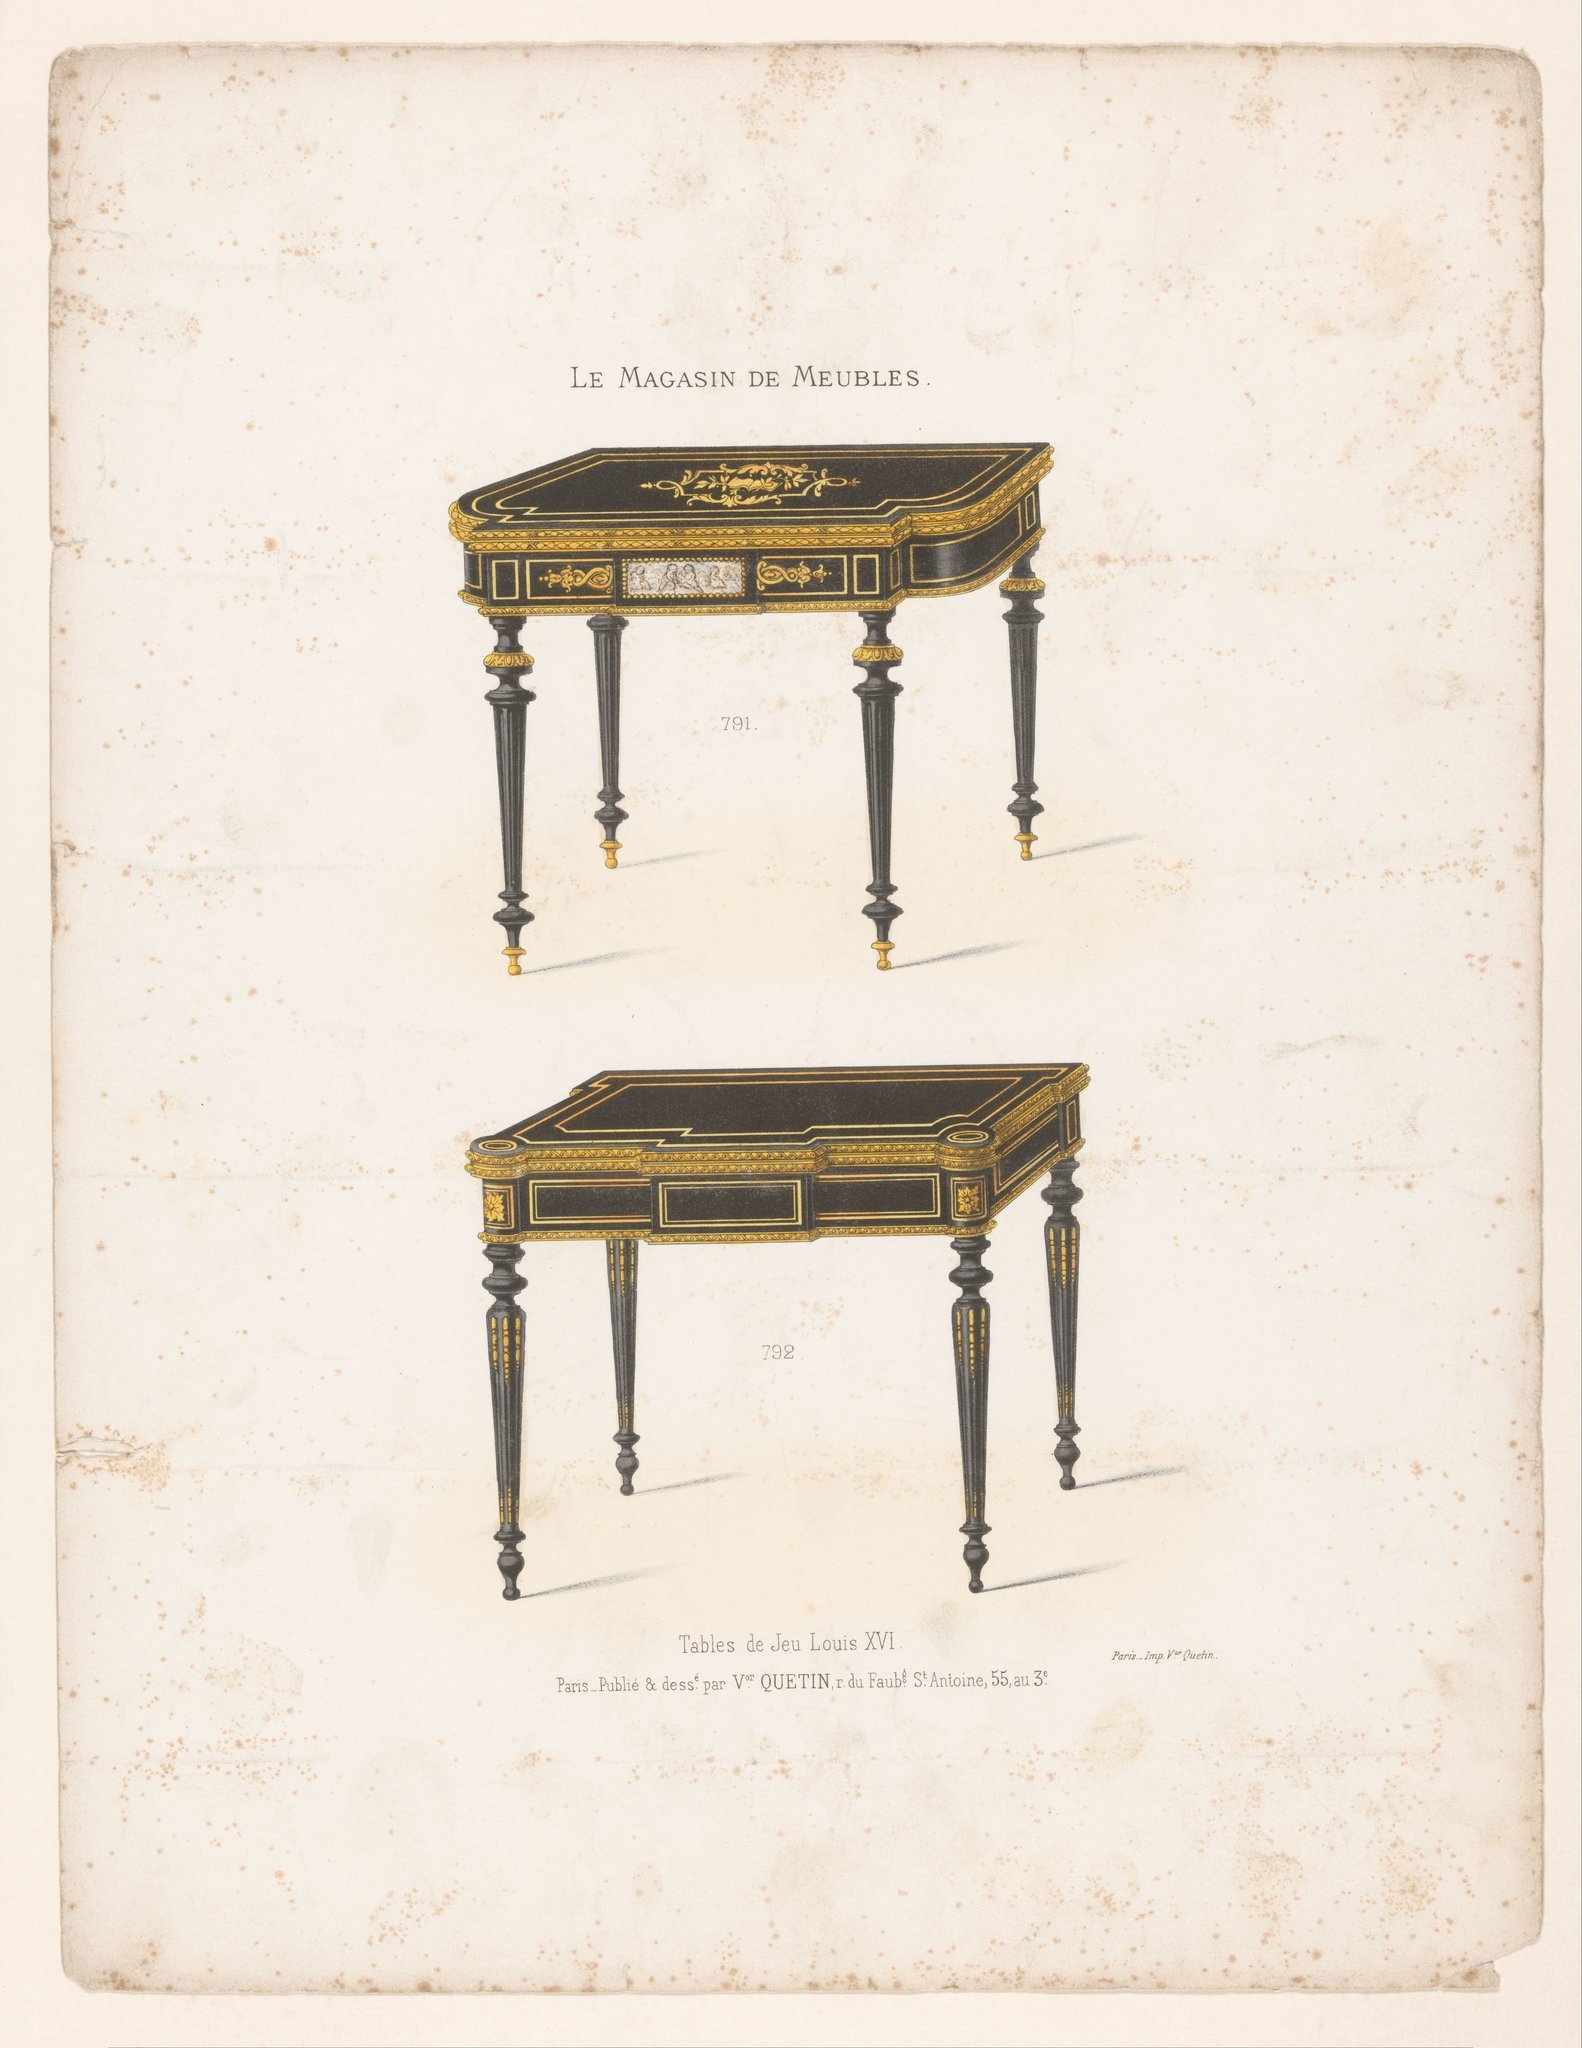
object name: print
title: Le Magasin de Meubles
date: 1832-1877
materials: paper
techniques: hand coloring, lithograph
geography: paris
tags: table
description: Twee speeltafels in de Lodewijk XVI-stijl.